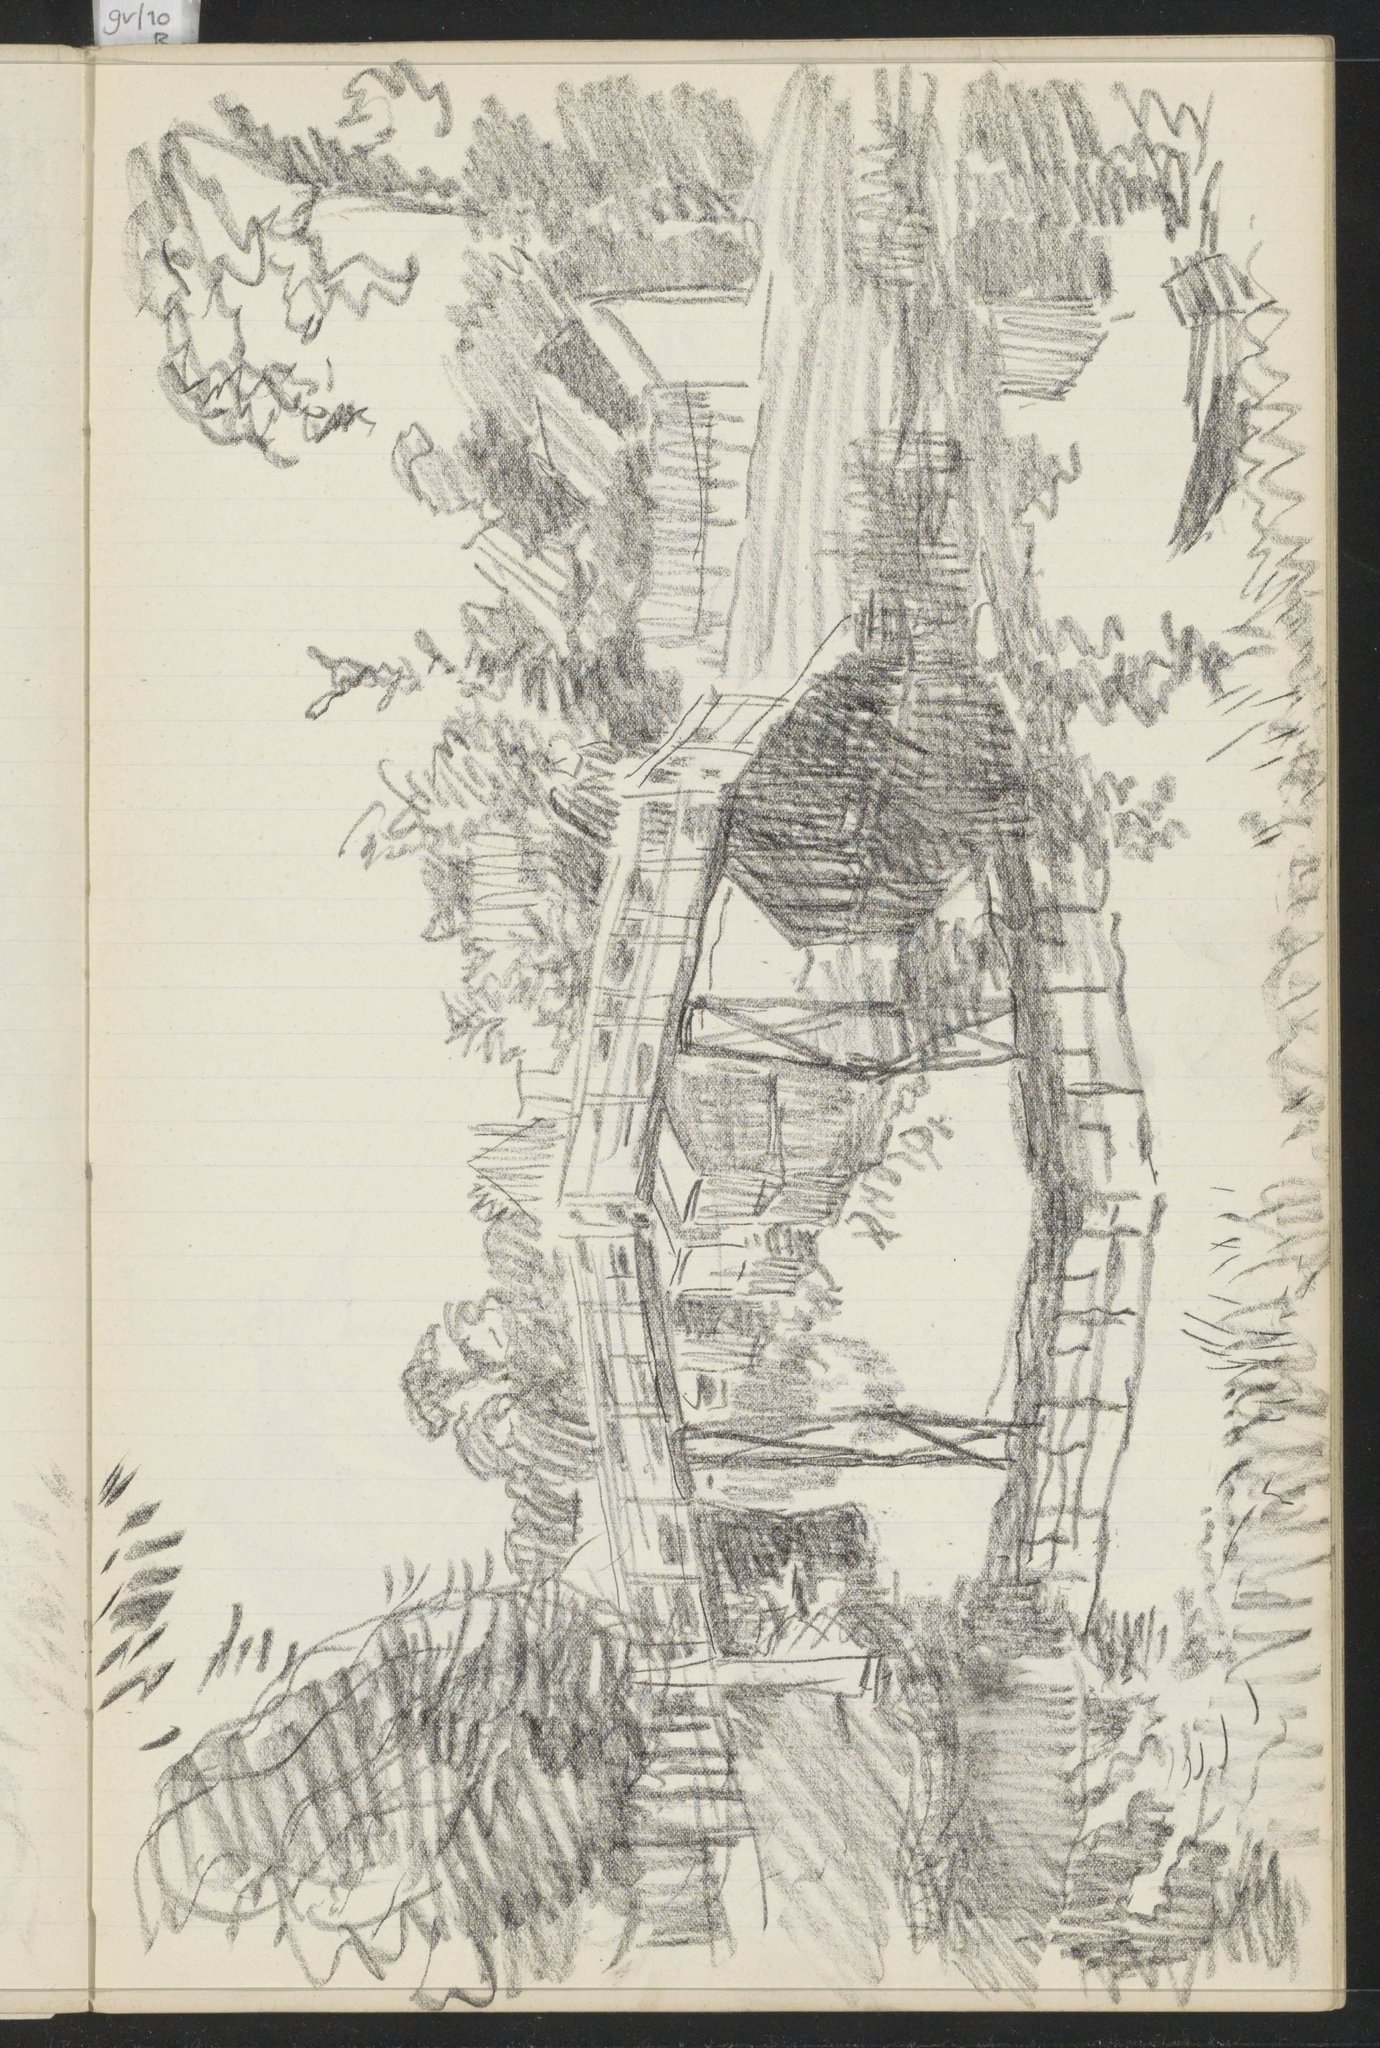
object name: sketchbook leaf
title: Brug over een rivier in een boomrijk landschap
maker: willem bastiaan tholen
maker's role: draughtsman, painter, print maker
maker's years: 1860-1931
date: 1900-1931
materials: chalk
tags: trees, landscapes with waters, waterscapes, seascapes (in the temperate zone), rowing-boat, canoe, etc., bridge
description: Blad 8 recto uit een schetsboek met 55 bladen.